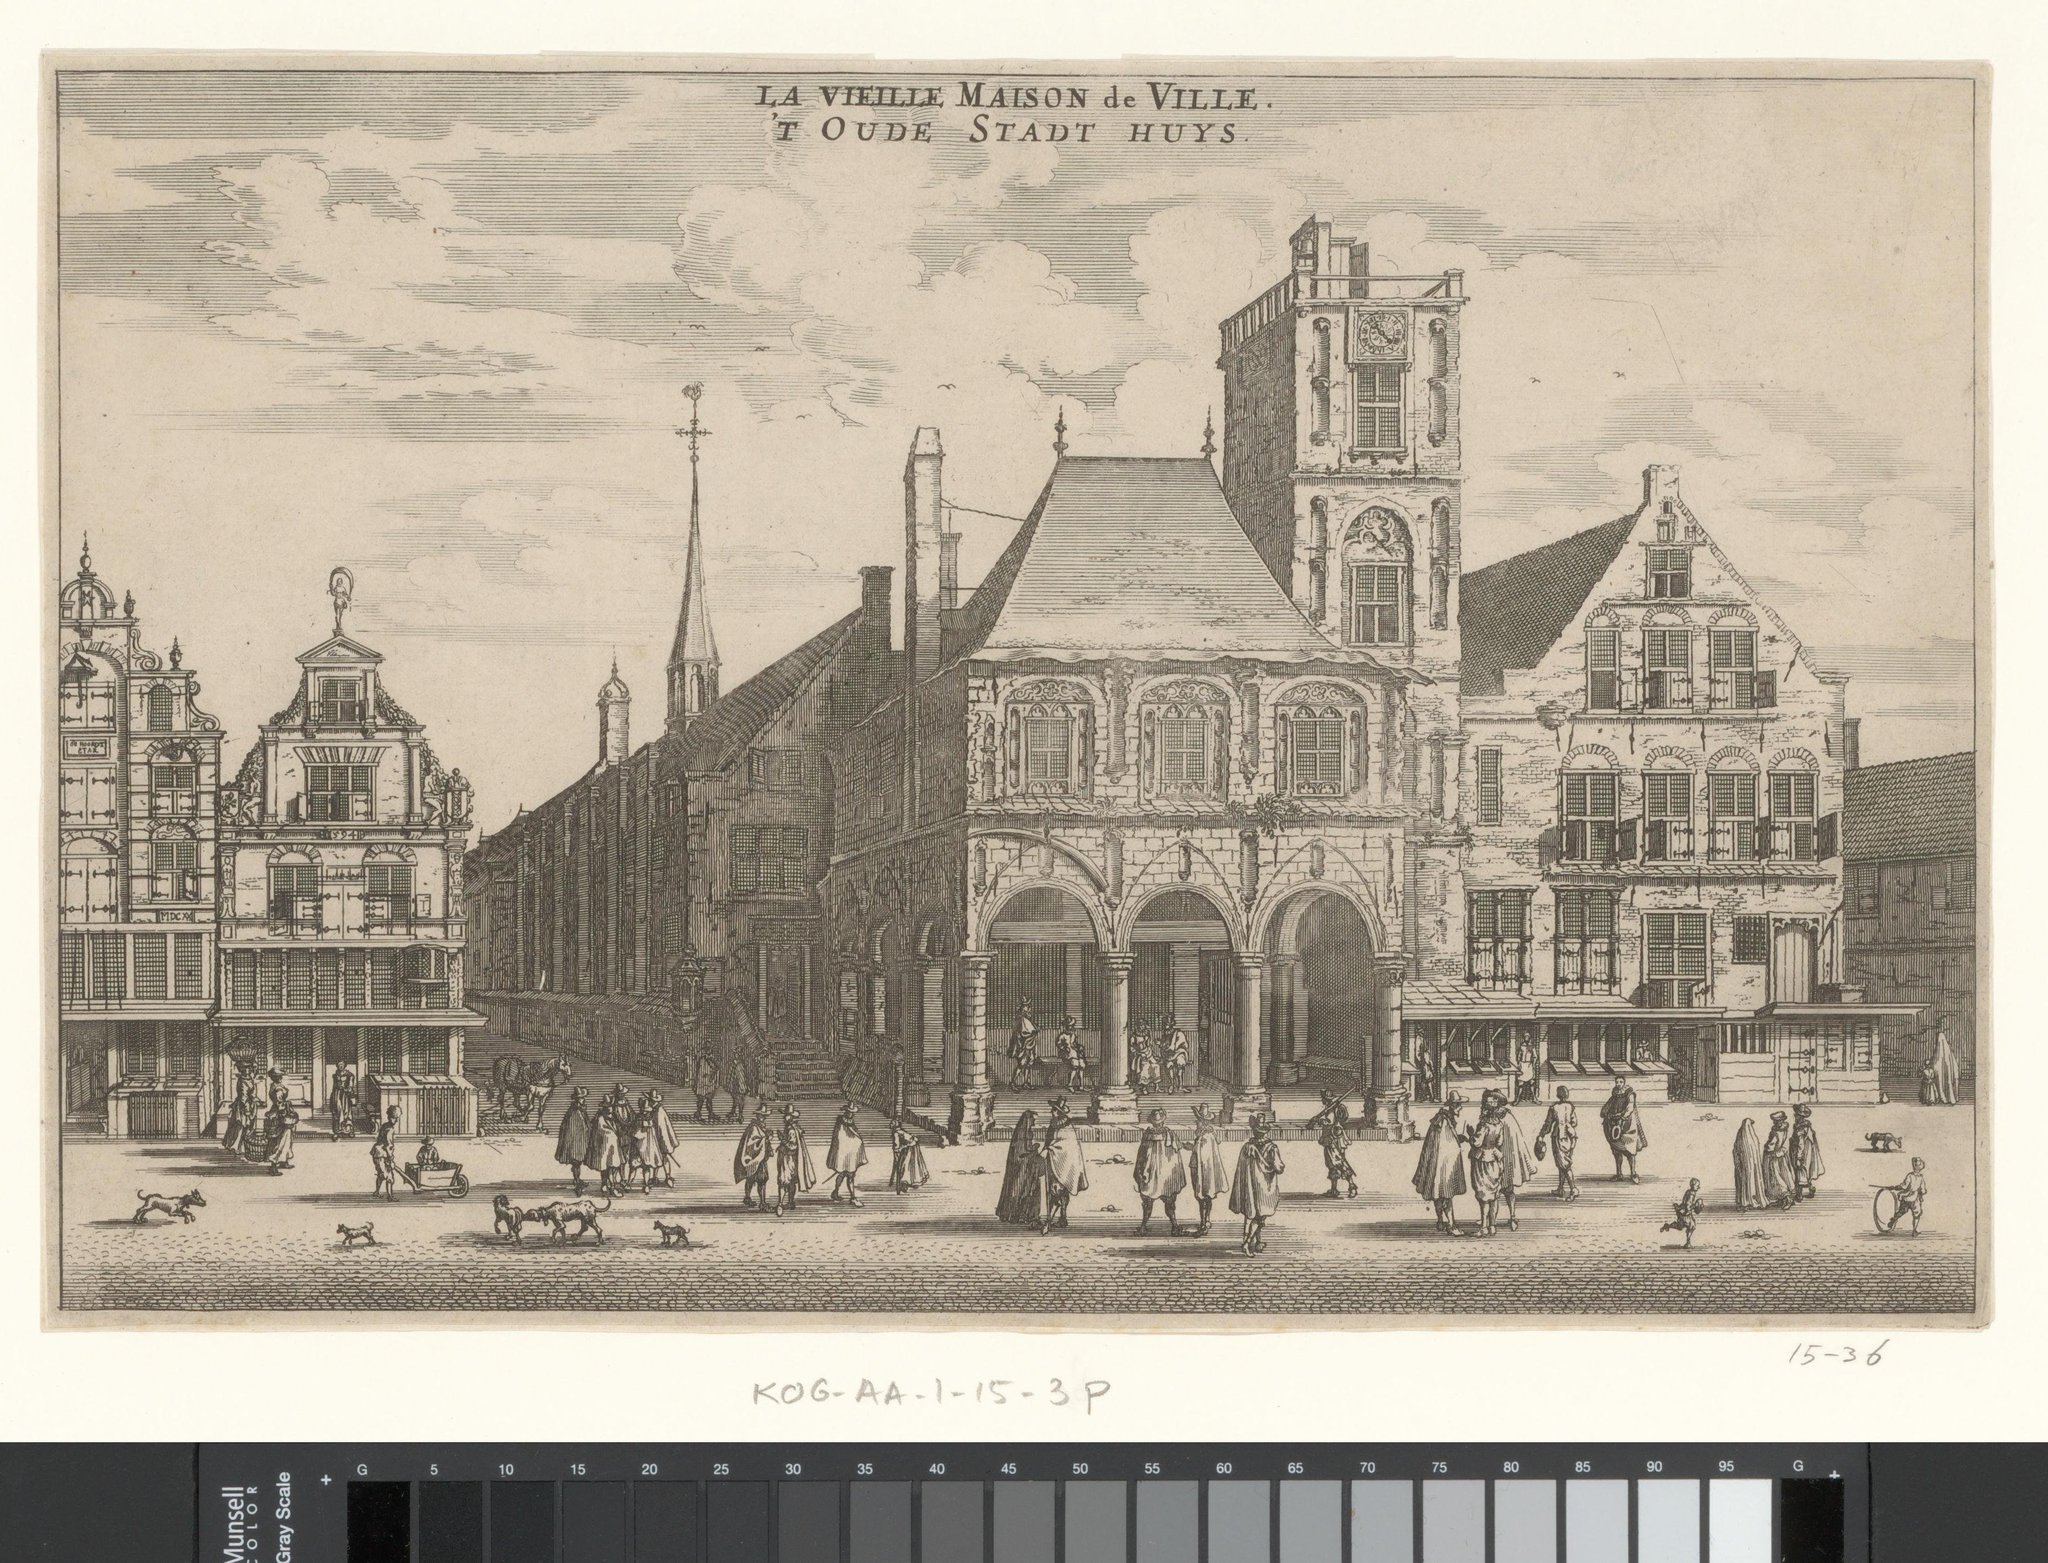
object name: print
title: Gezicht op het oude stadhuis van Amsterdam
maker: jacob van meurs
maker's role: draughtsman, print maker, publisher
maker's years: 1619-1680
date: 1663-1664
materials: paper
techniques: engraving, etching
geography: amsterdam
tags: square, place, circus, etc., city-view in general; 'veduta', townhall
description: Prent gebruikt in: Dapper, Olfert. Historische beschryving der stadt Amsterdam: waer in de voornaemste geschiedenissen (na een kort verhael van gansch Hollant en d'omleggende dorpen (…). Amsterdam: Jacob van Meurs, 1663.* En in: Zesen, Philipp von. Beschreibung der Stadt Amsterdam: darinnen von derselben ersten Ursprunge bis auf gegenwärtigen Zustand (…). Amsterdam: Joachim Nosche, 1664. * In sommige exemplaren van deze uitgave komt de huidige staat van de prent voor. In andere exemplaren is een eerdere staat ingebonden, waarop enkel de Nederlandse titel is toegevoegd.